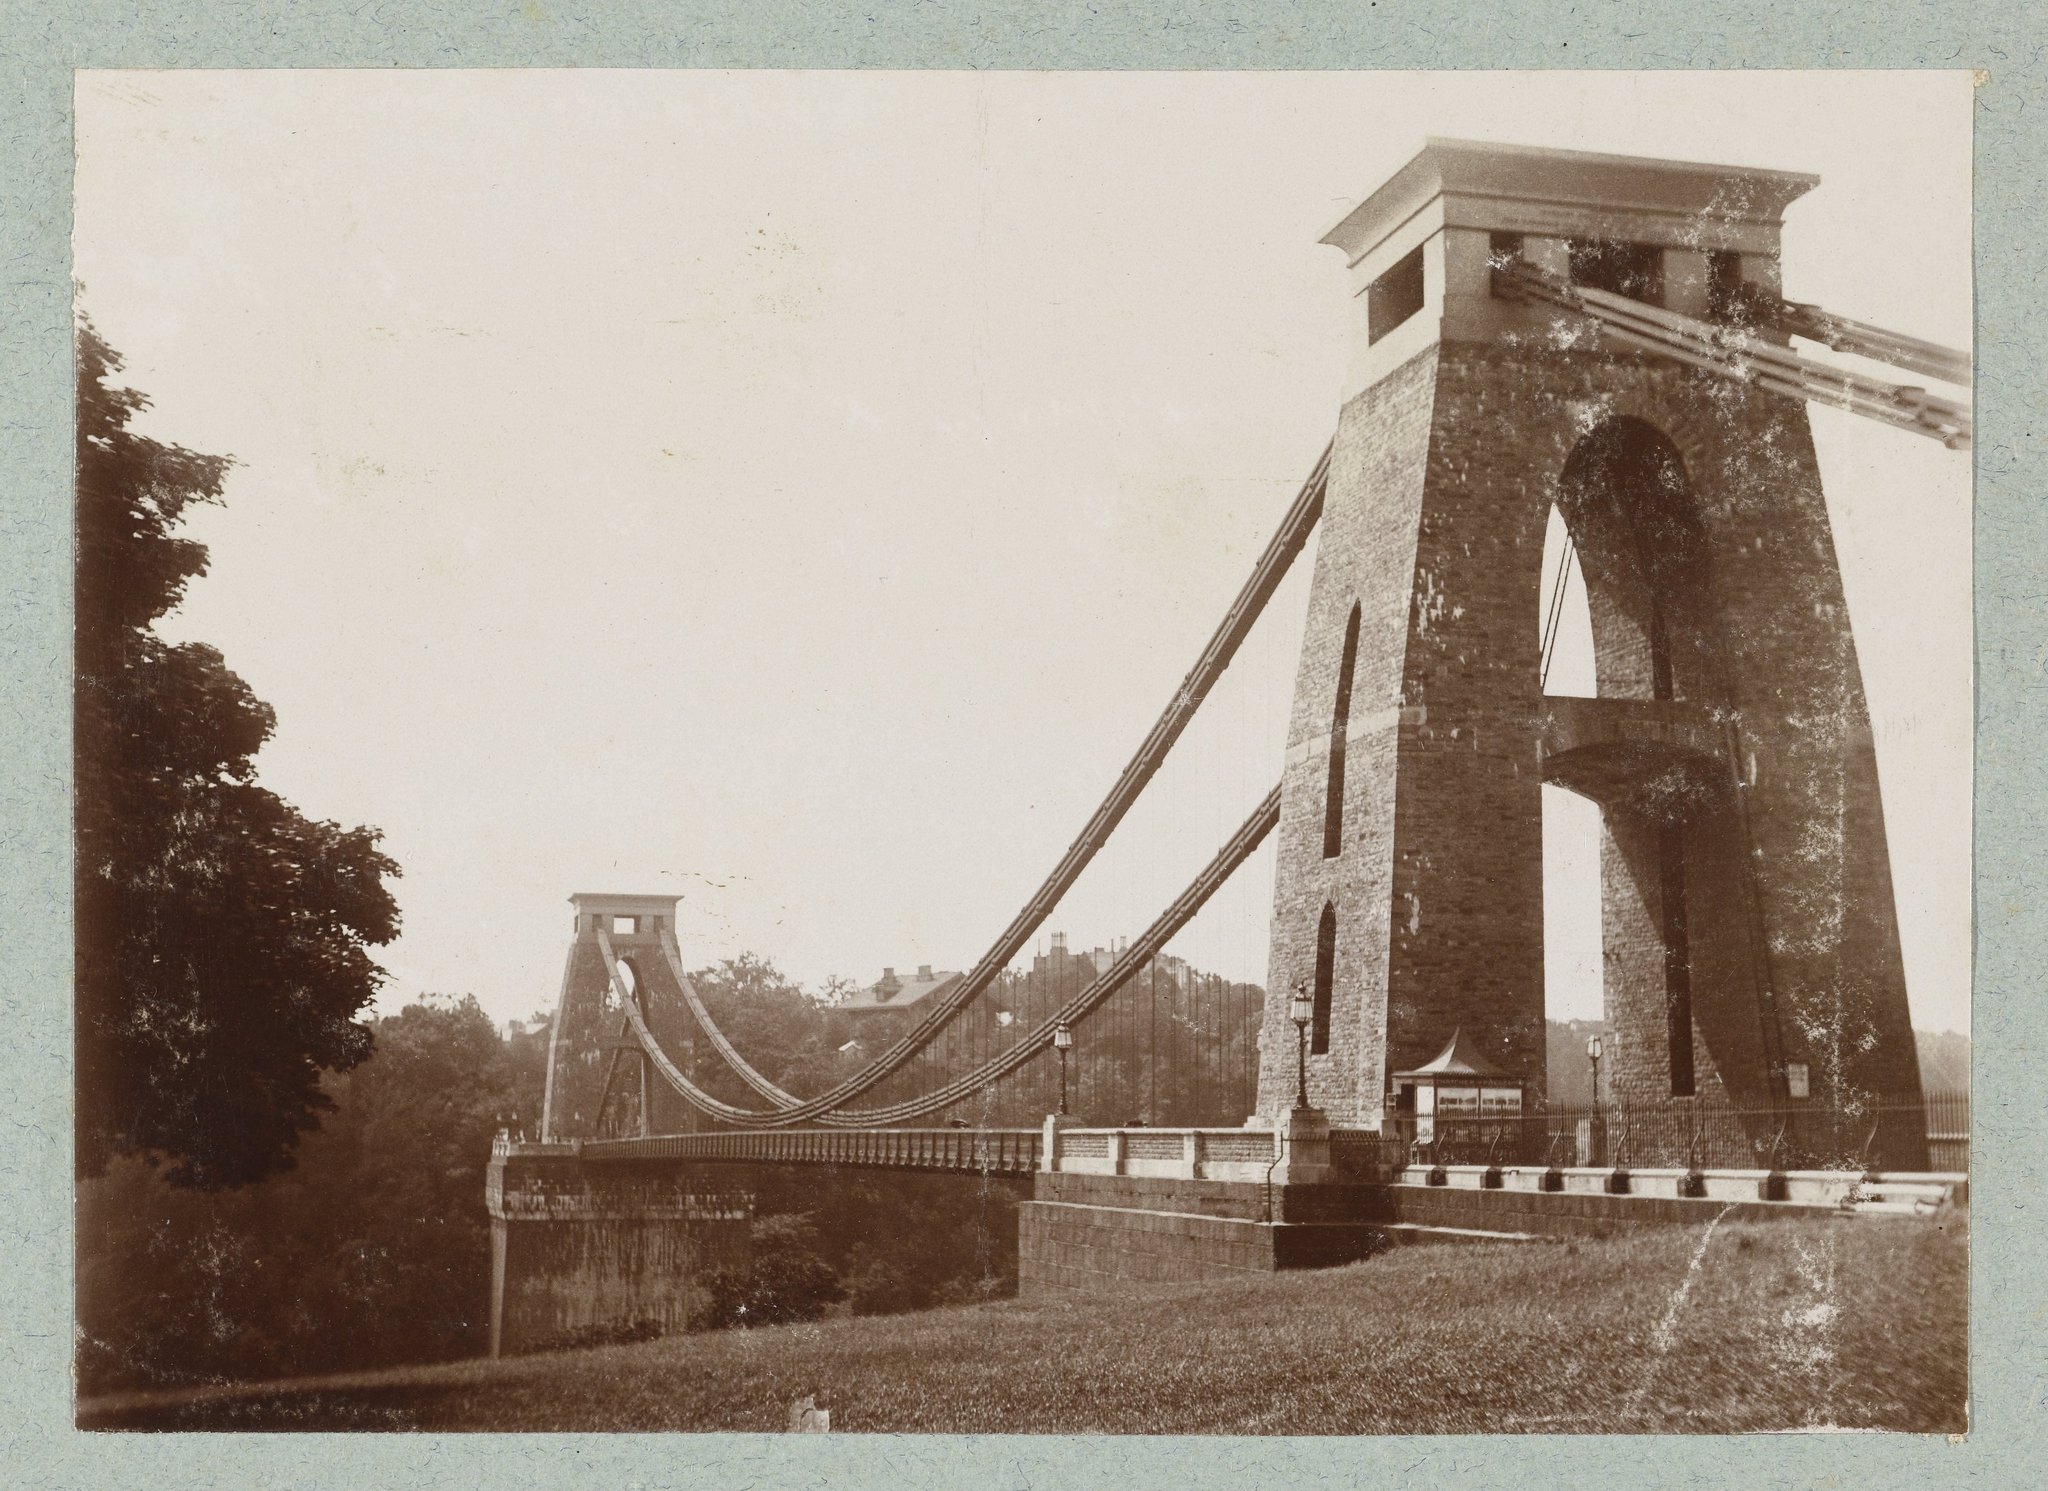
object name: photograph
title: De Clifton Suspension Bridge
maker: frits freerks fontein fz.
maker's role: fotograaf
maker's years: 1882-1928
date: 1901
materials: cardboard, paper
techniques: gelatin silver print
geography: england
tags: bristol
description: De Clifton Suspension Bridge ( hangbrug) over de kloof waarin de rivier de Avon loopt bij Bristol. Foto uit album 'Photographieën". Foto uit album 'Photographieën".